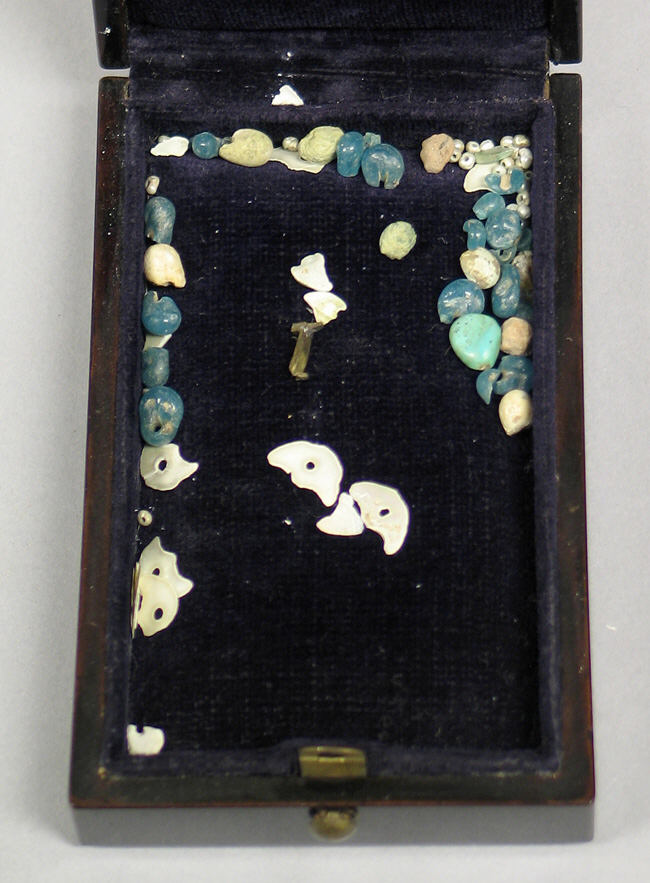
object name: box of remnant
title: Box of Remnants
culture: chinese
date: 618-907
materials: glass, mother of pearl, paste, pearl